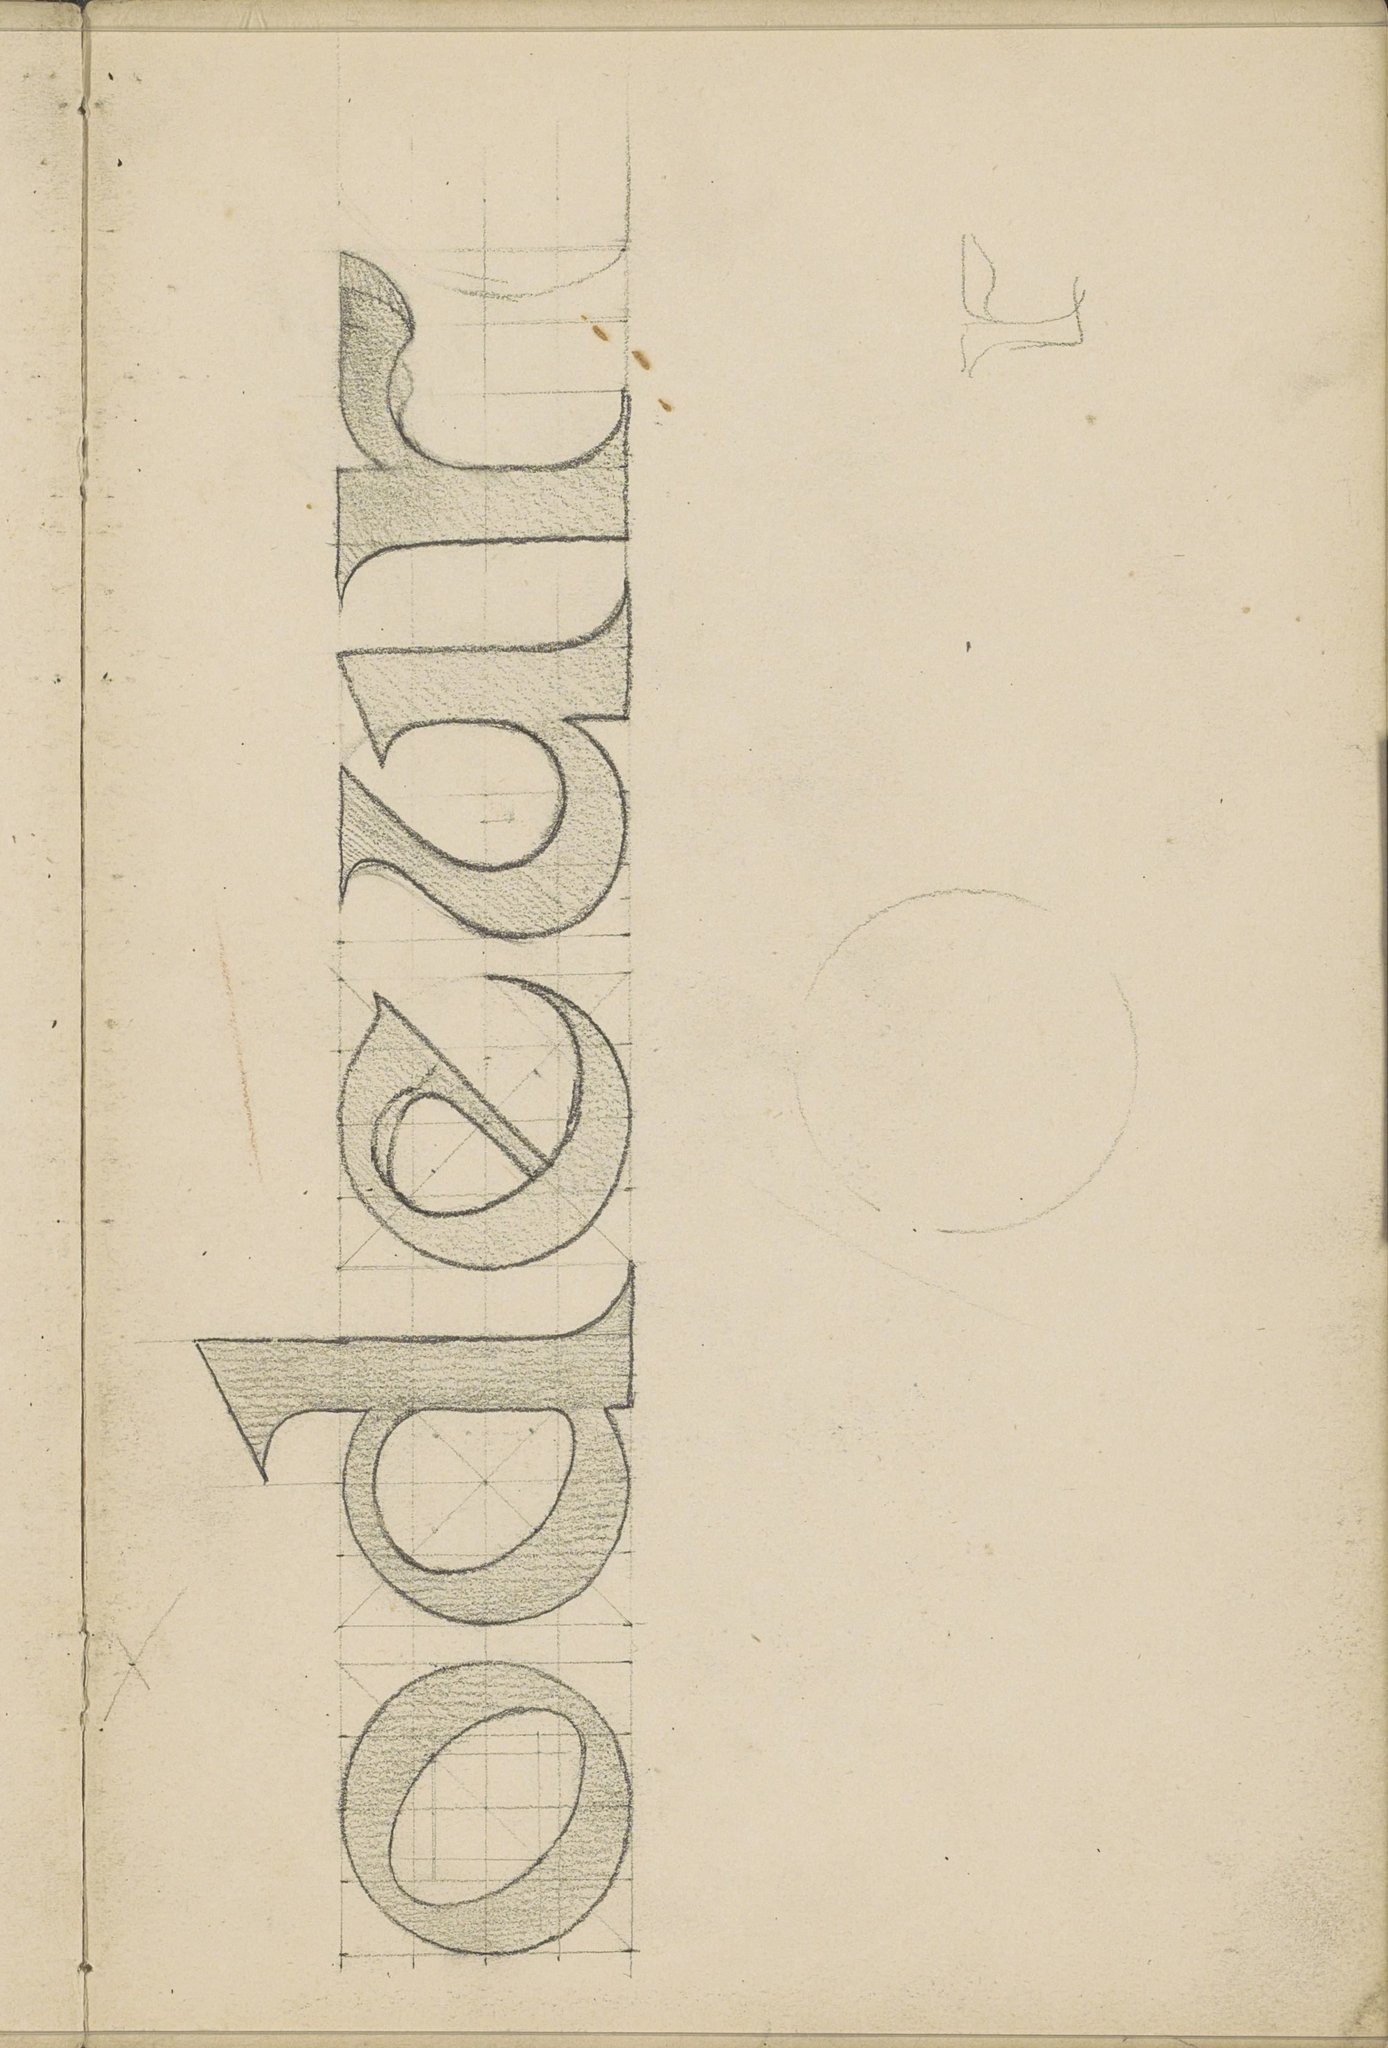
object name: sketchbook leaf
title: 'Odeur' in sierletters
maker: antoon derkinderen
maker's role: draughtsman, painter, print maker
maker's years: 1859-1925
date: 1889-1894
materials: paper, pencil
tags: fancy letters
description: Tevens een letter 'r'. Blad 26 recto uit een schetsboek met 33 bladen.